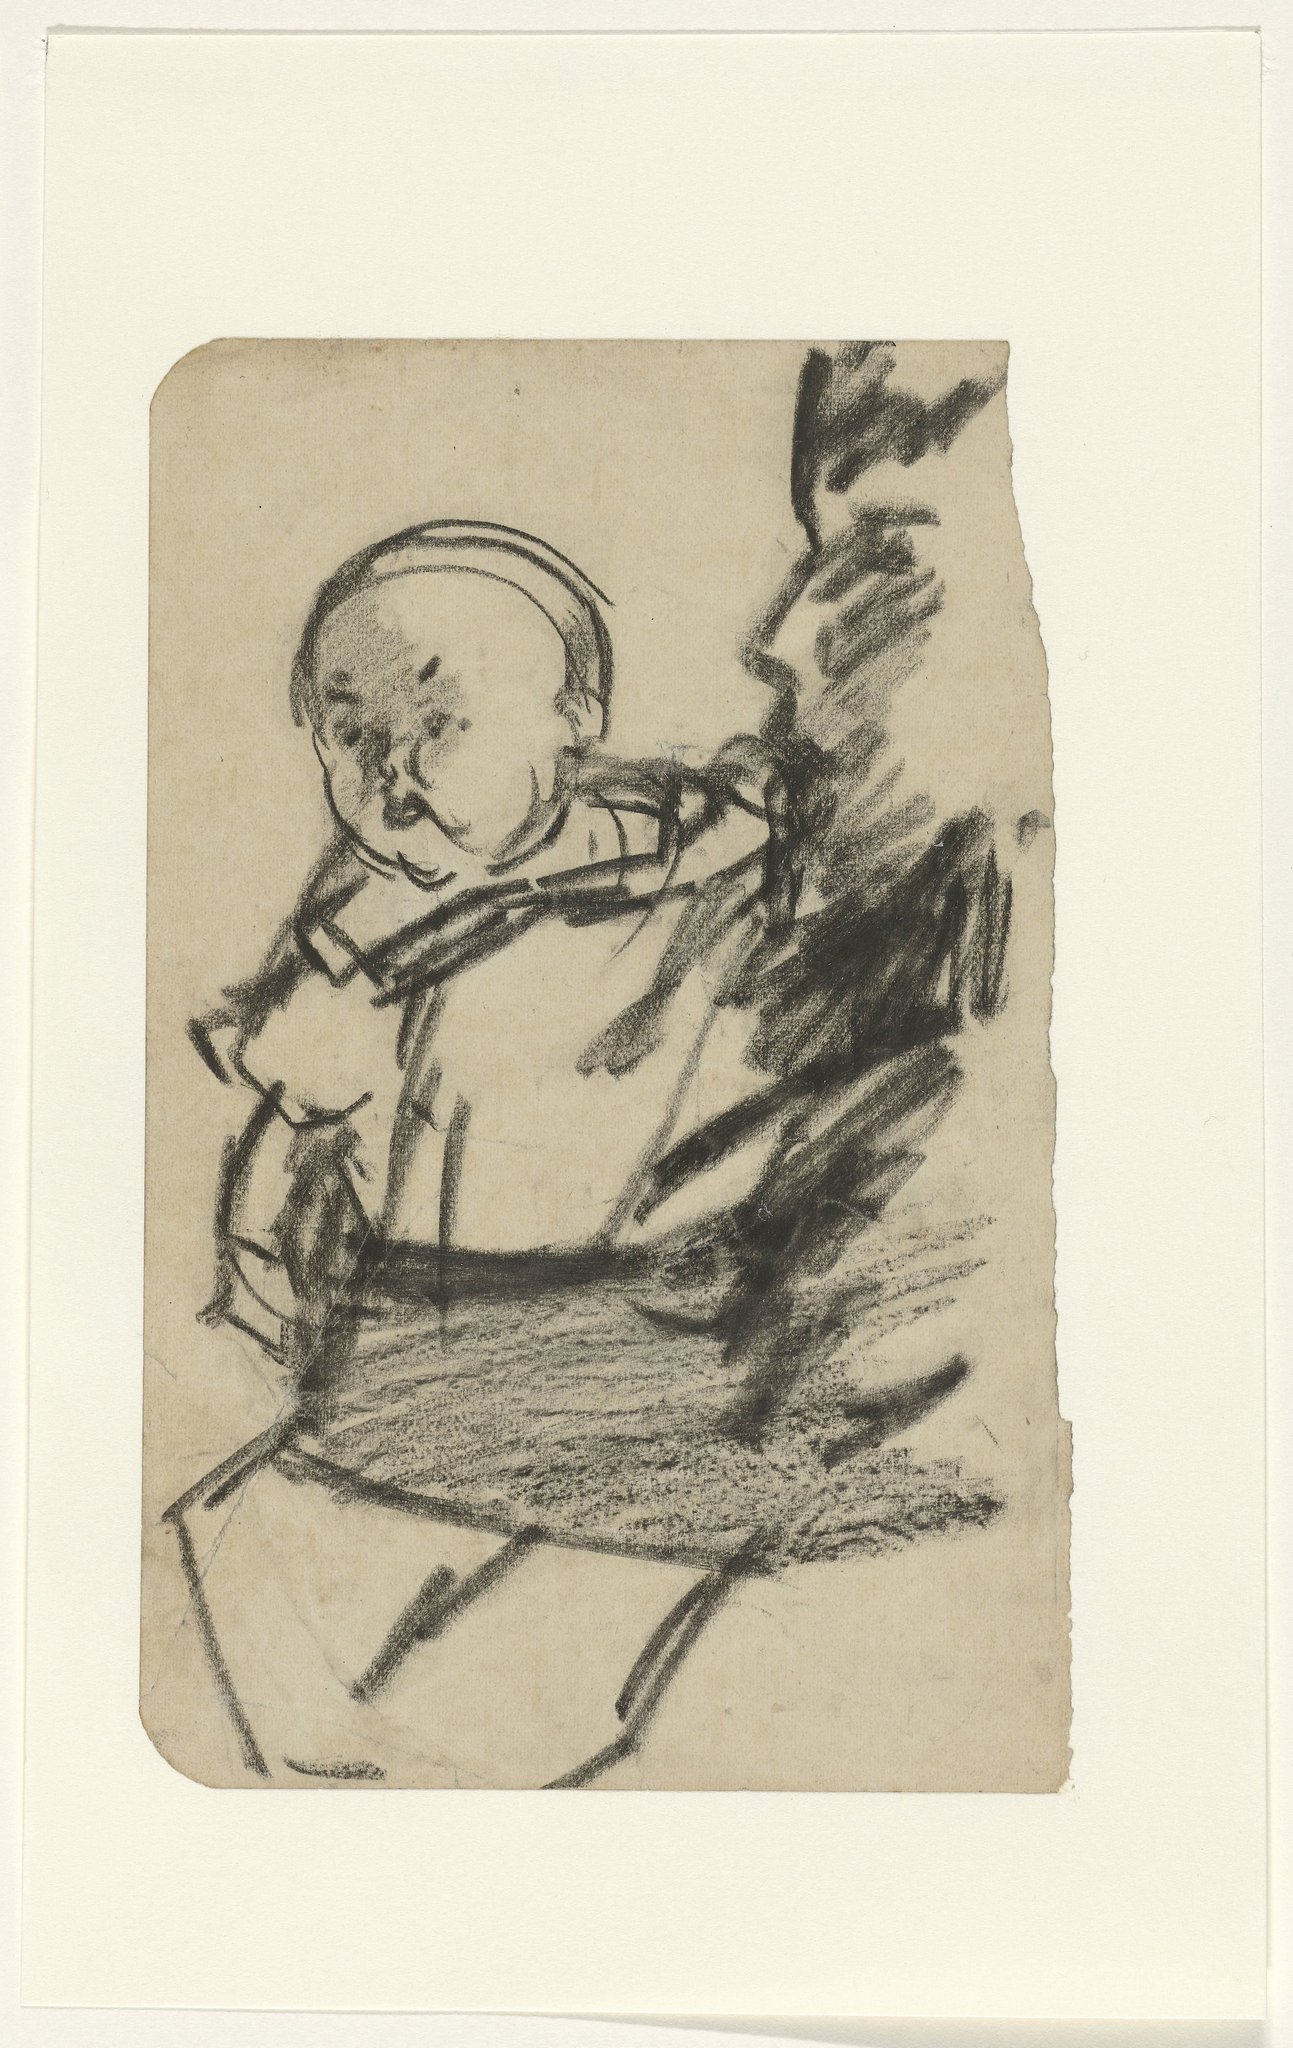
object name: drawing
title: Moeder met kind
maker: isaac israels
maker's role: draughtsman, painter, print maker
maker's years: 1865-1934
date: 1875-1934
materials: chalk, paper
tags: mother and baby or young child